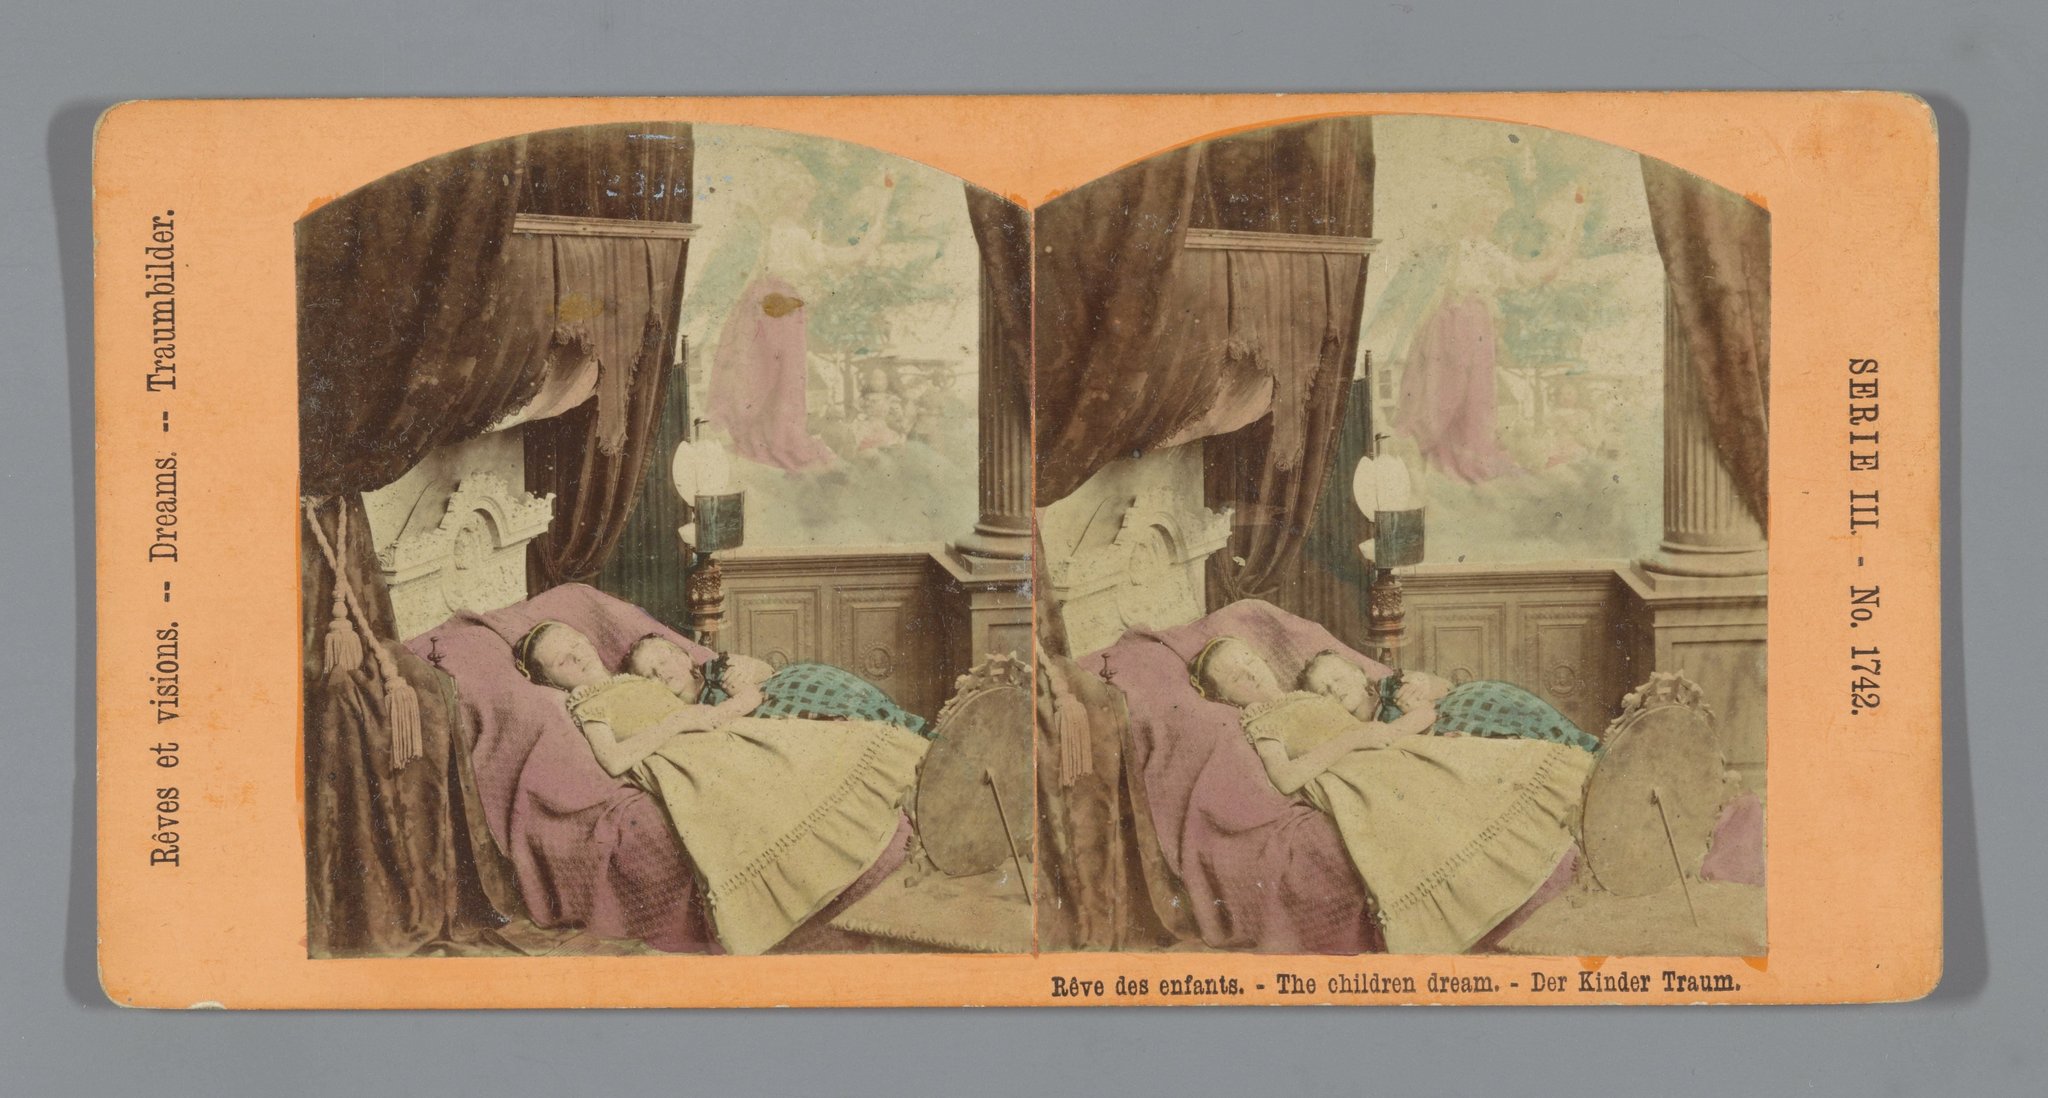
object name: stereograph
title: Rêve des enfants / The children dream / Der Kinder Traum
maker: Anonymous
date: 1868-1890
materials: cardboard, paper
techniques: albumen print, hand coloring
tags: child, dream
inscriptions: inscription: ‘SERIE III - No. 1742.’